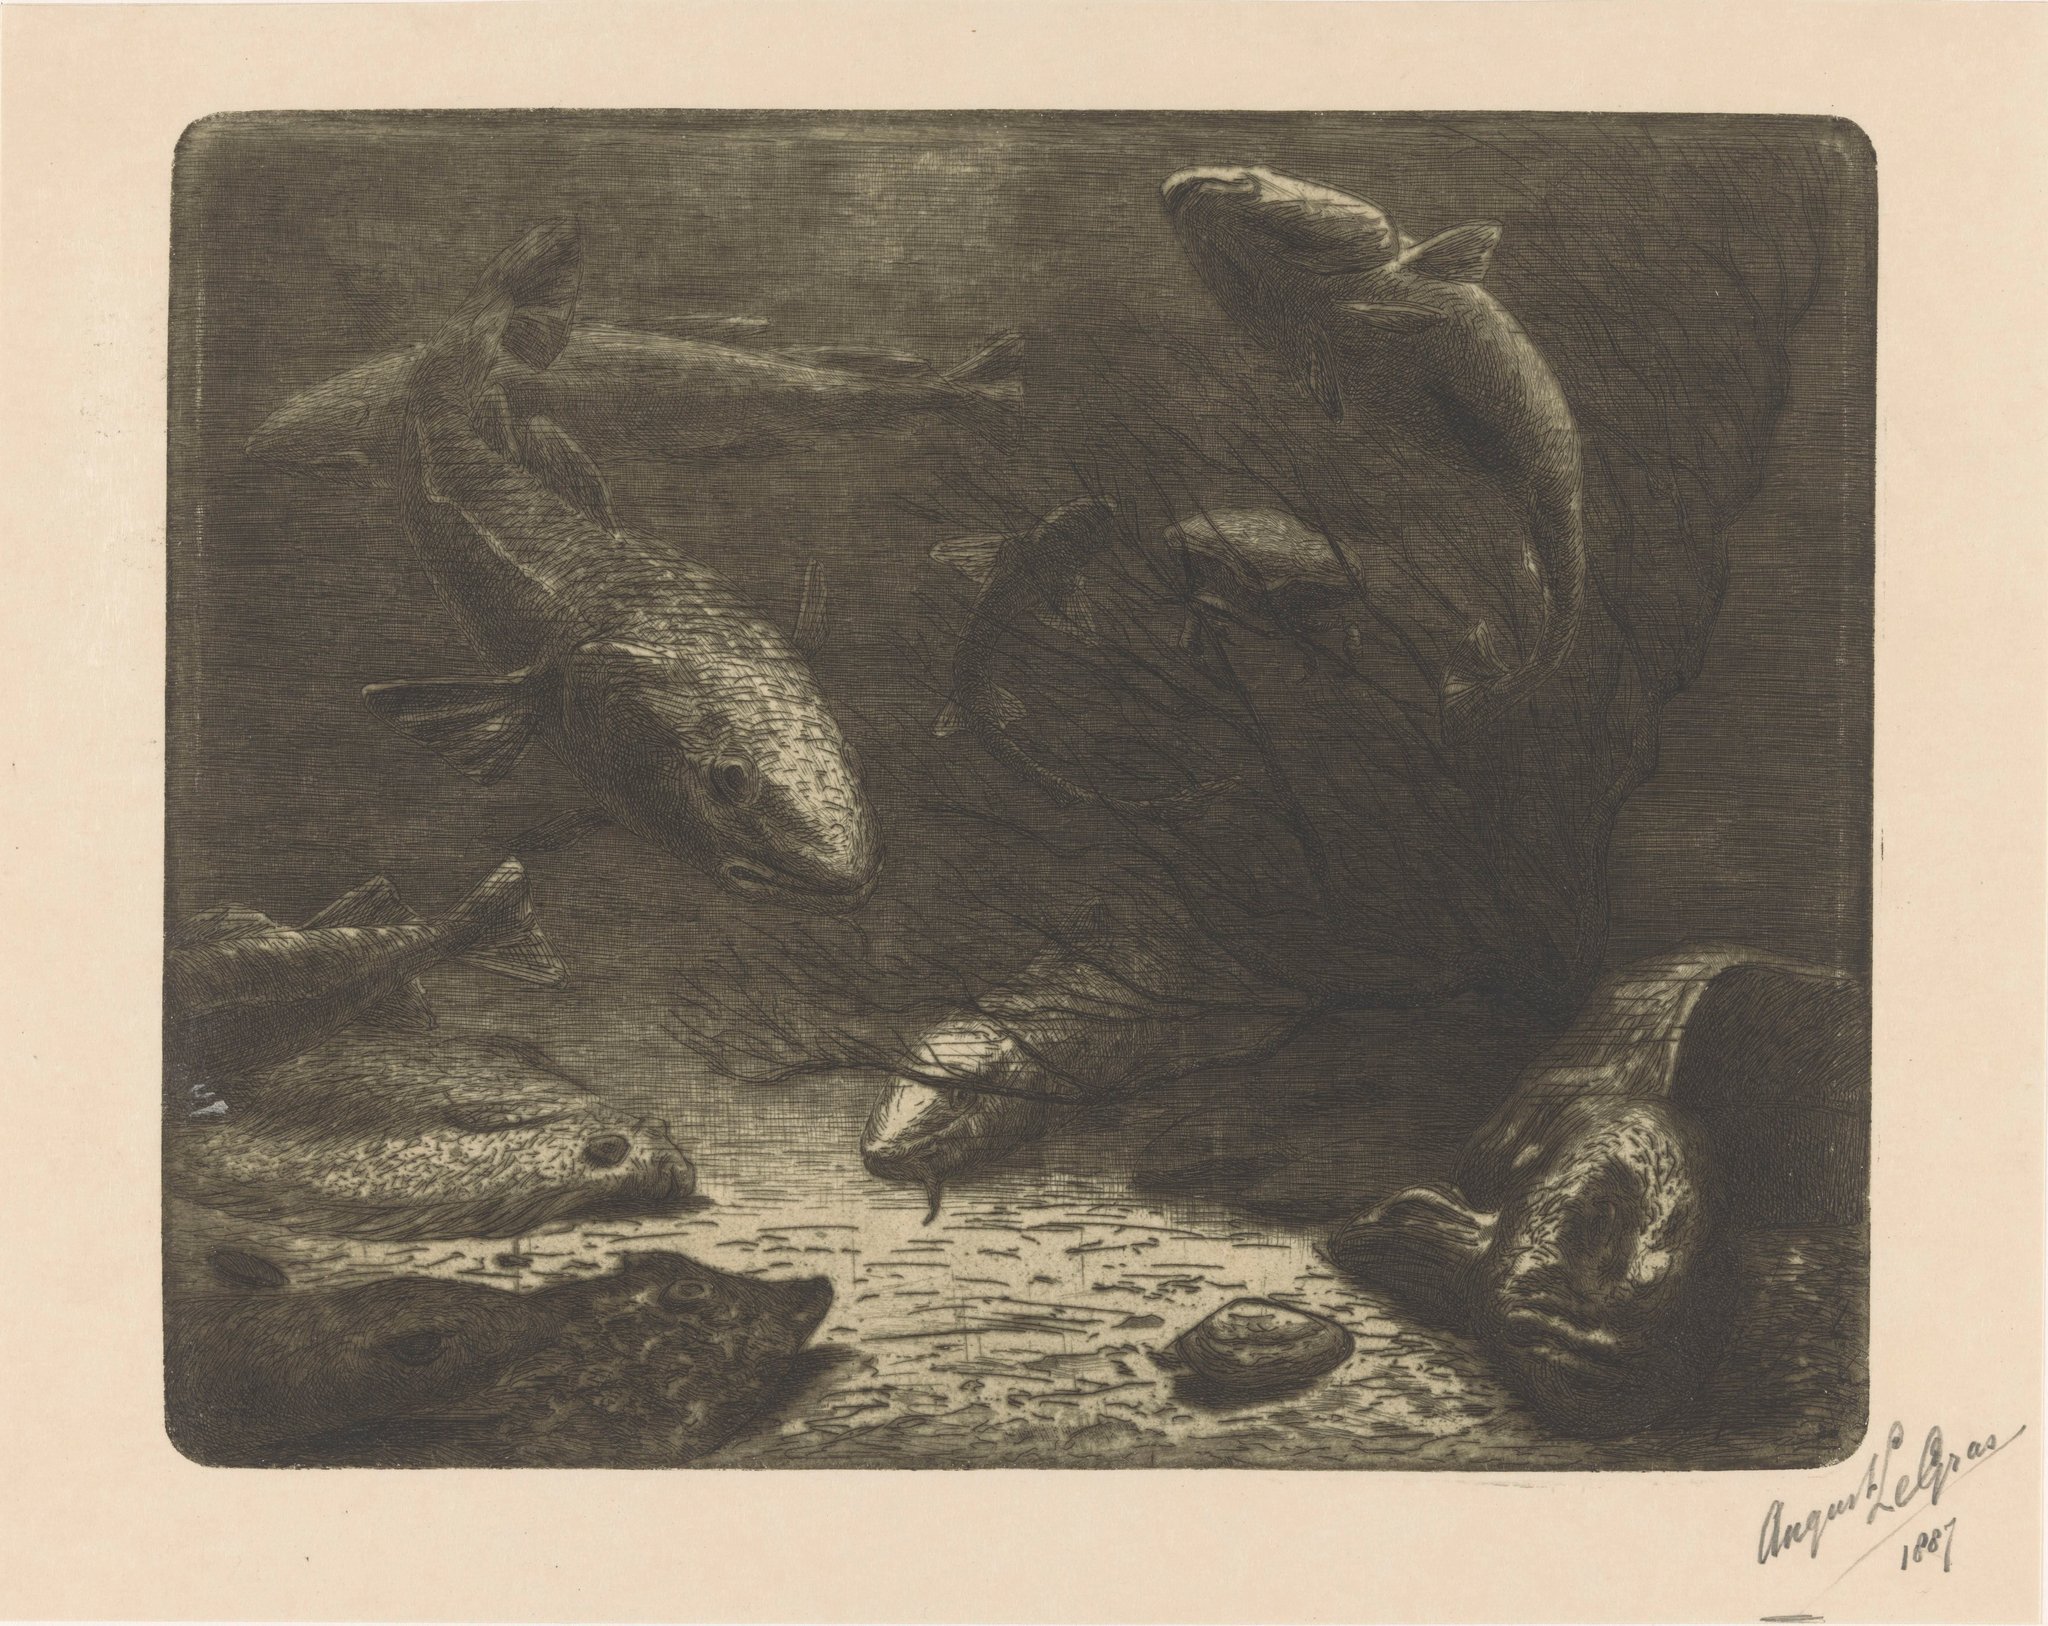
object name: print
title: Aquarium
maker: august le gras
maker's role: draughtsman, print maker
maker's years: 1864-1915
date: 1887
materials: paper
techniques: drypoint, etching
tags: aquarium, crustaceans: crab, bony fishes: plaice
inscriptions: collector's mark: Lugt 2233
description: Aquarium met elf vissen en een krab. Links liggen twee schollen op de bodem. Rechts een waterplant.